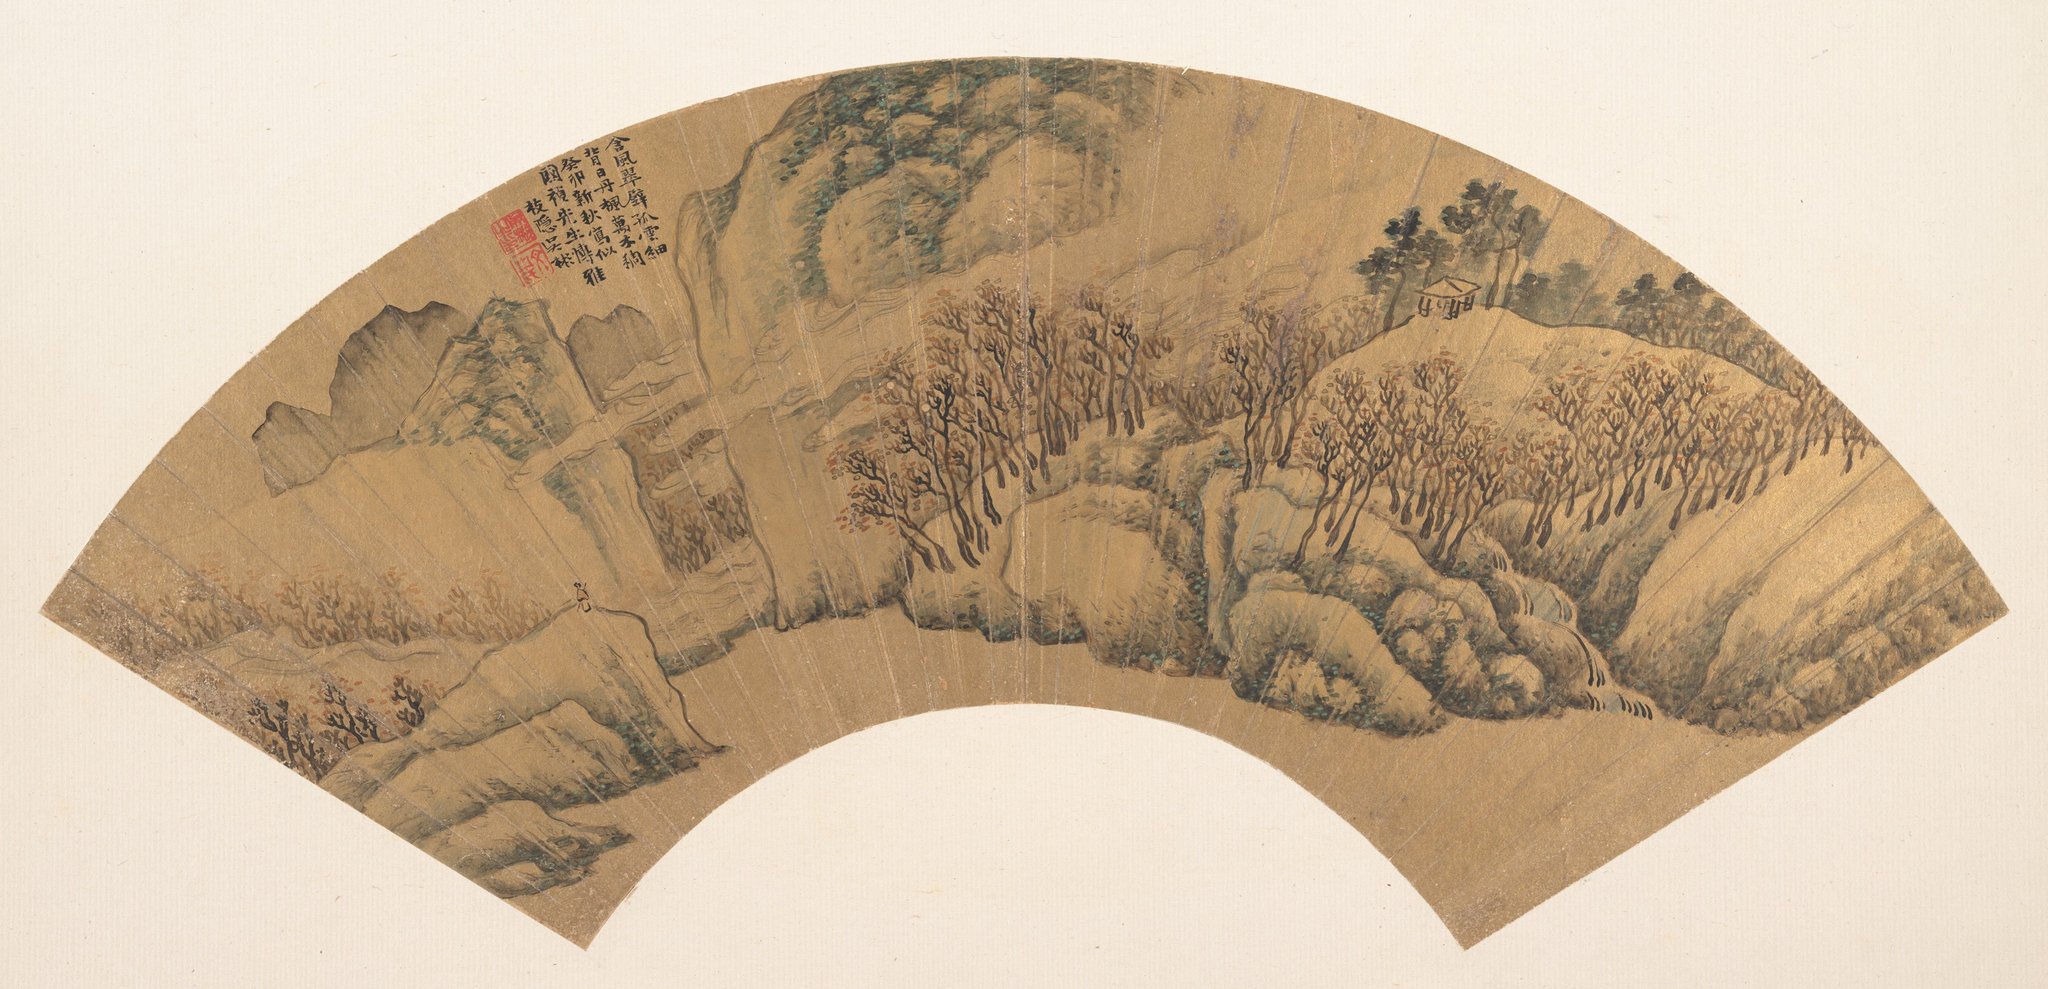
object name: folding fan mounted a an album leaf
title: Azure Cliff with Red Maples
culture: chinese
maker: wu bin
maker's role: artist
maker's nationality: chinese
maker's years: 1583-1626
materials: ink, paper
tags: landscapes